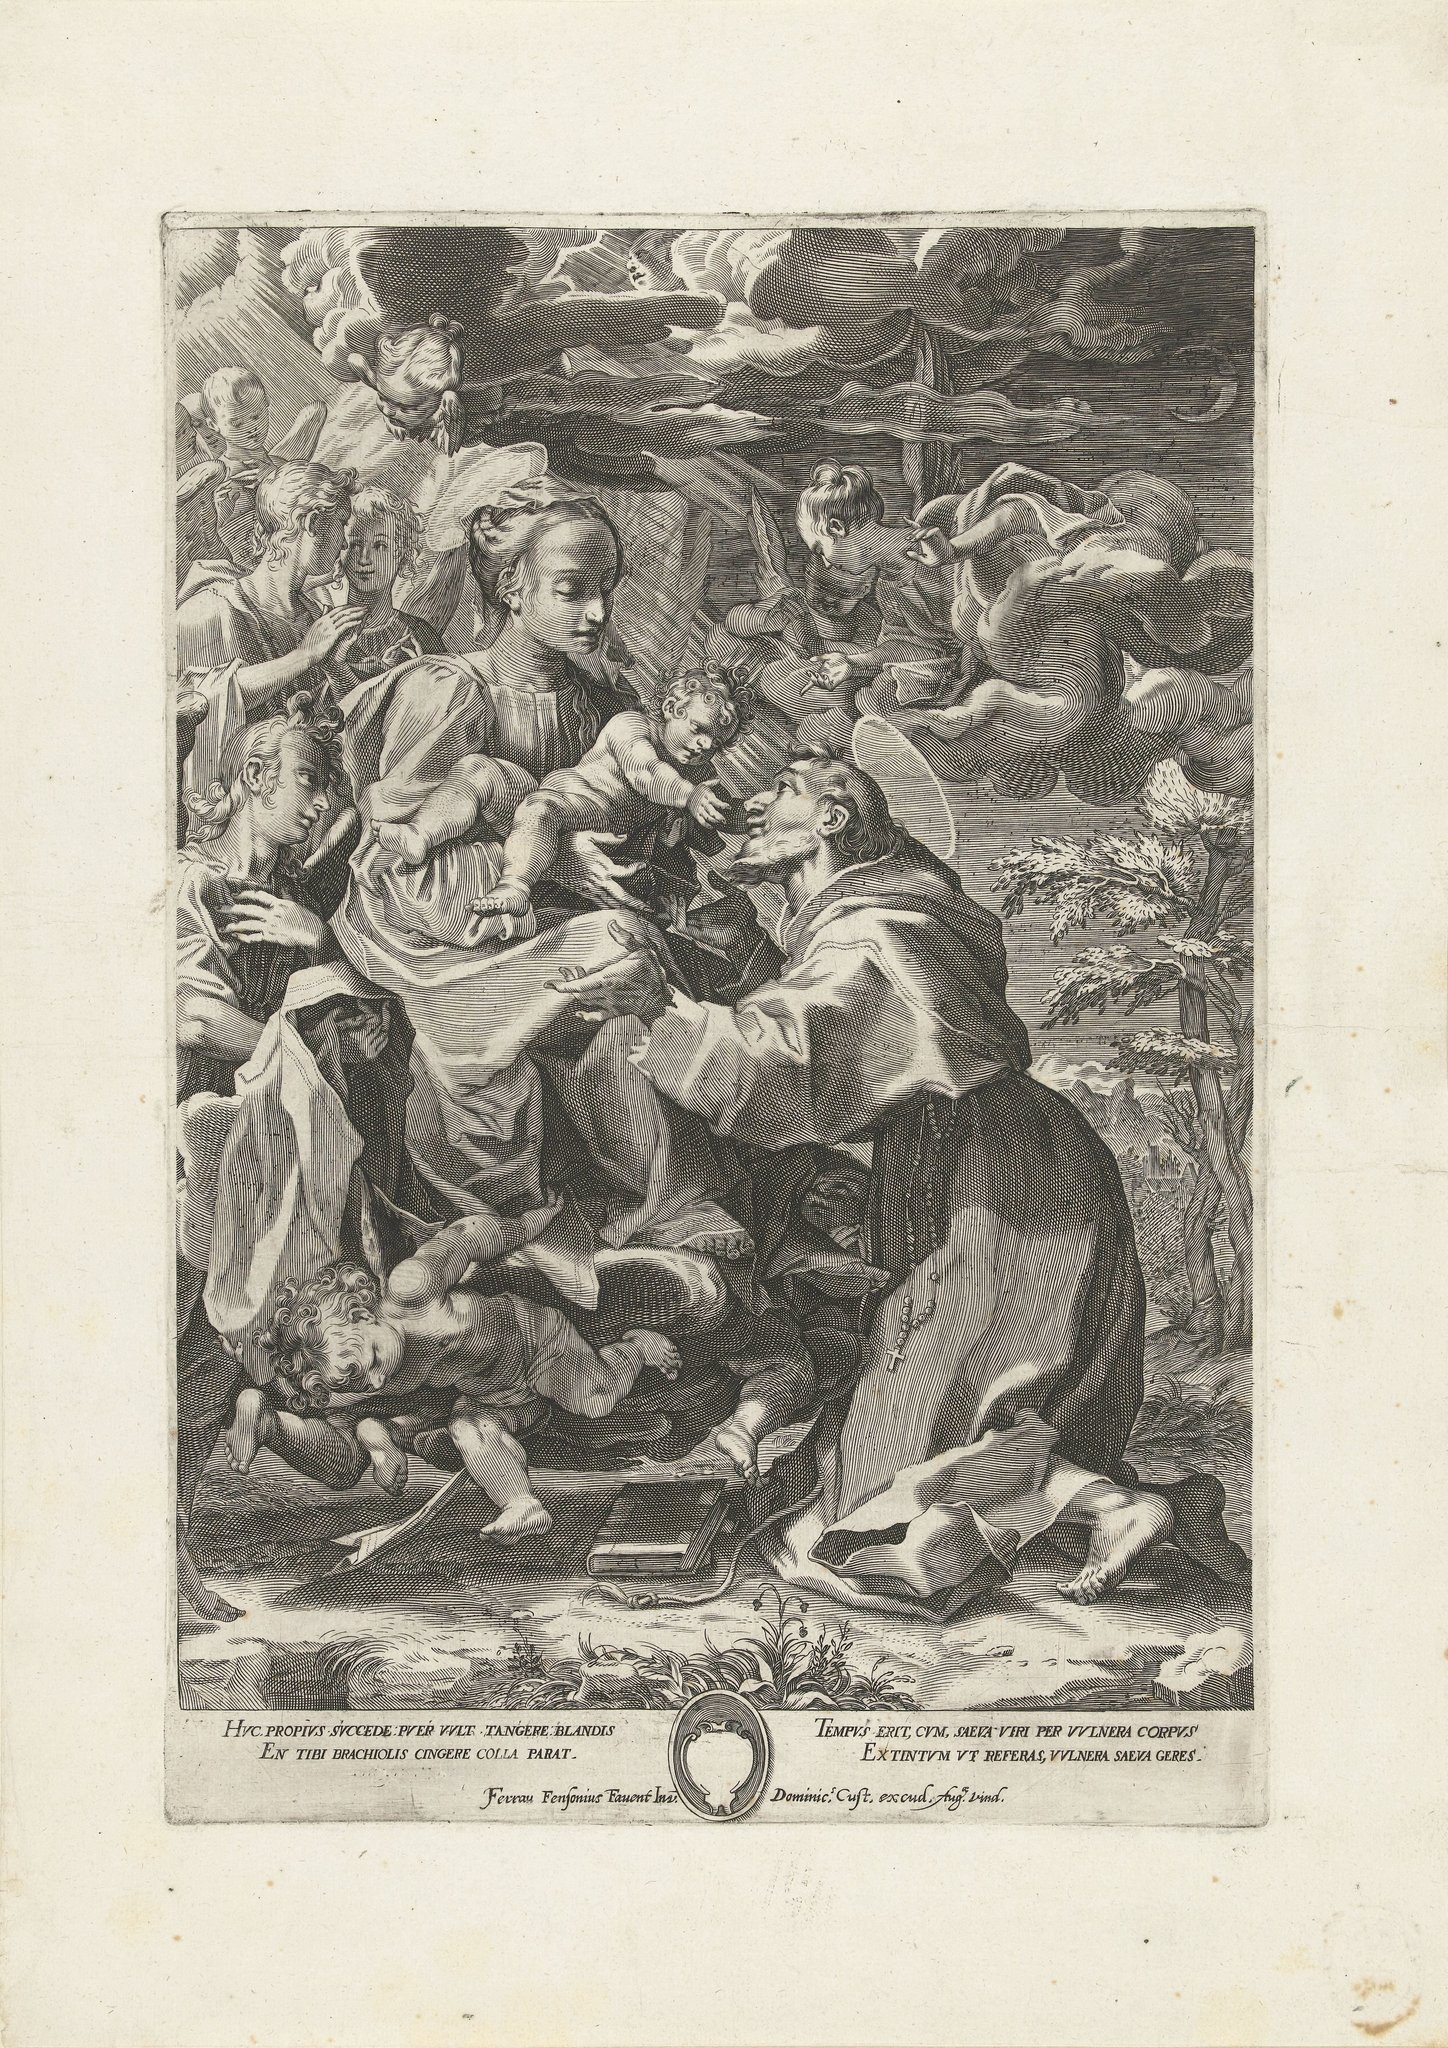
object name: print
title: Maria met Kind en een heilige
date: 1579-1615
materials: paper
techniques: engraving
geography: augsburg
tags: madonna (or mary without christ-child) as patroness or protectress, e.g. of a confraternity or lay order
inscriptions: collector's mark: Lugt 240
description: Tronende Maria met het Kind in haar armen. Om haar heen engelen. Een heilige met monnikspij, rozenkrans en boek aanbidt Maria en het Kind.